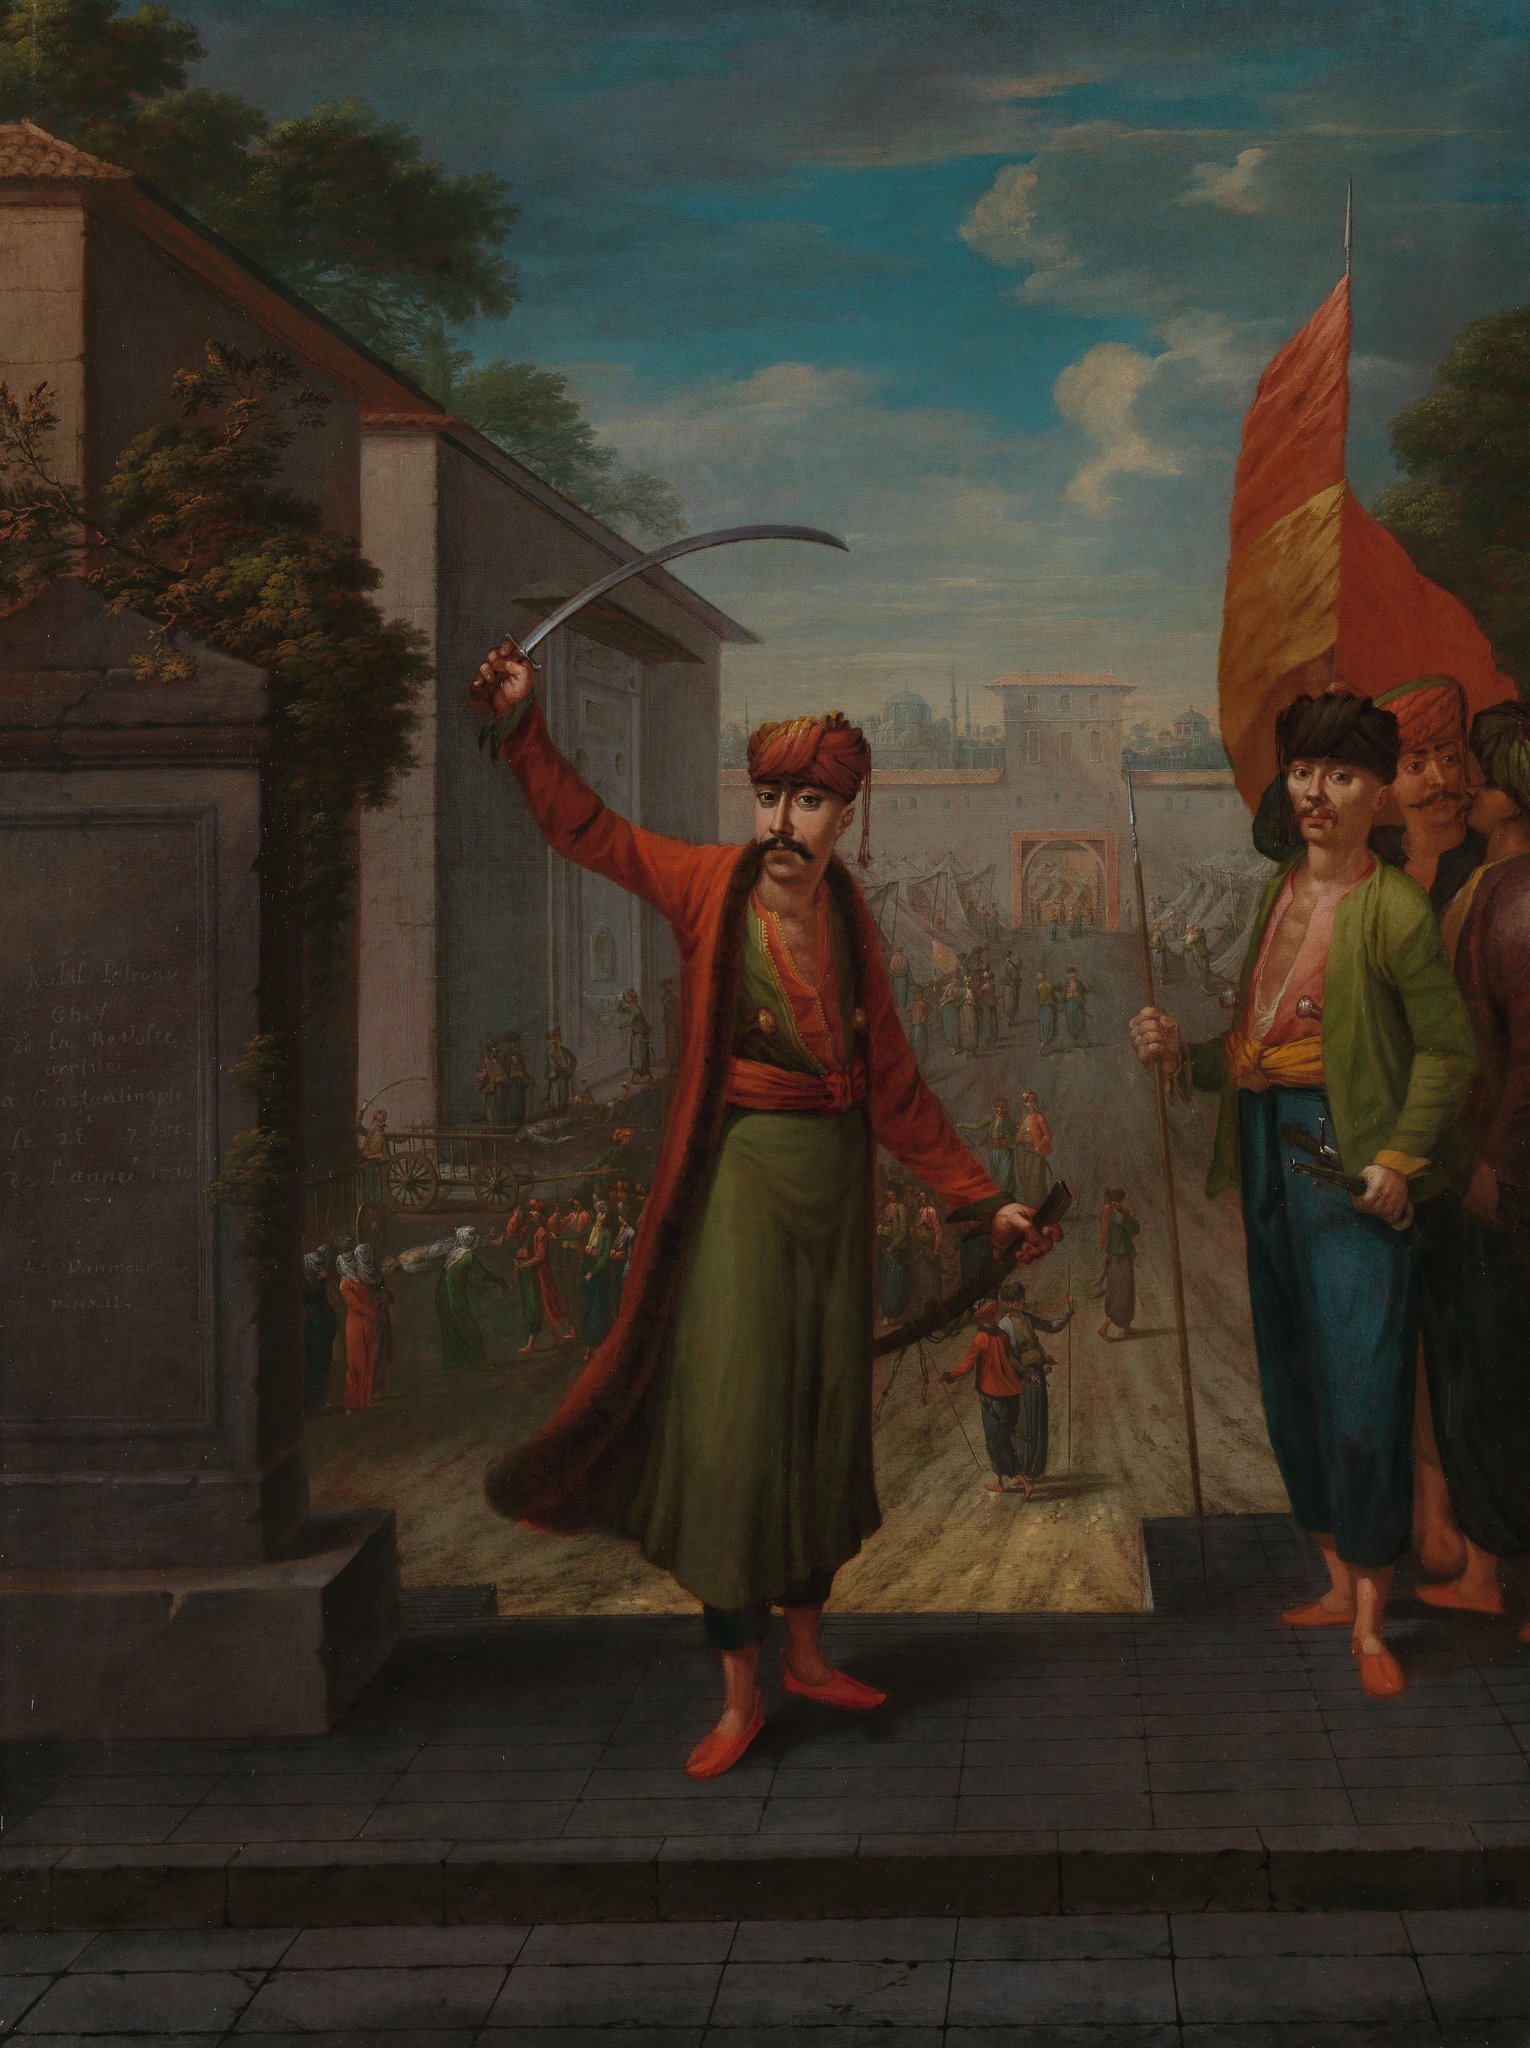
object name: painting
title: Patrona Halil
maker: jean baptiste vanmour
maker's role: painter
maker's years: 1671-1737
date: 1730-1737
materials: canvas, oil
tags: hacking and thrusting weapons: sword, revolution, revolt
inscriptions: signature: ‘I.B. Vanmour pinxit.’, inscription: ‘Kalil Patrona Chef de Révolte arrivée à Constantinople le 28 7bre de l'année 1730.’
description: The lavish feasts given by Ahmed III incited riots. A mob uprising led by Patrona Halil, an Albanian sailor, broke out on 28 September 1730. The sultan abdicated, and his nephew Mahmud I was installed as his successor. The bodies of those who died during the revolt are being carried away in the left distance. This is the only signed painting by Vanmour in Calkoen’s collection; his name appears on the stone at left.